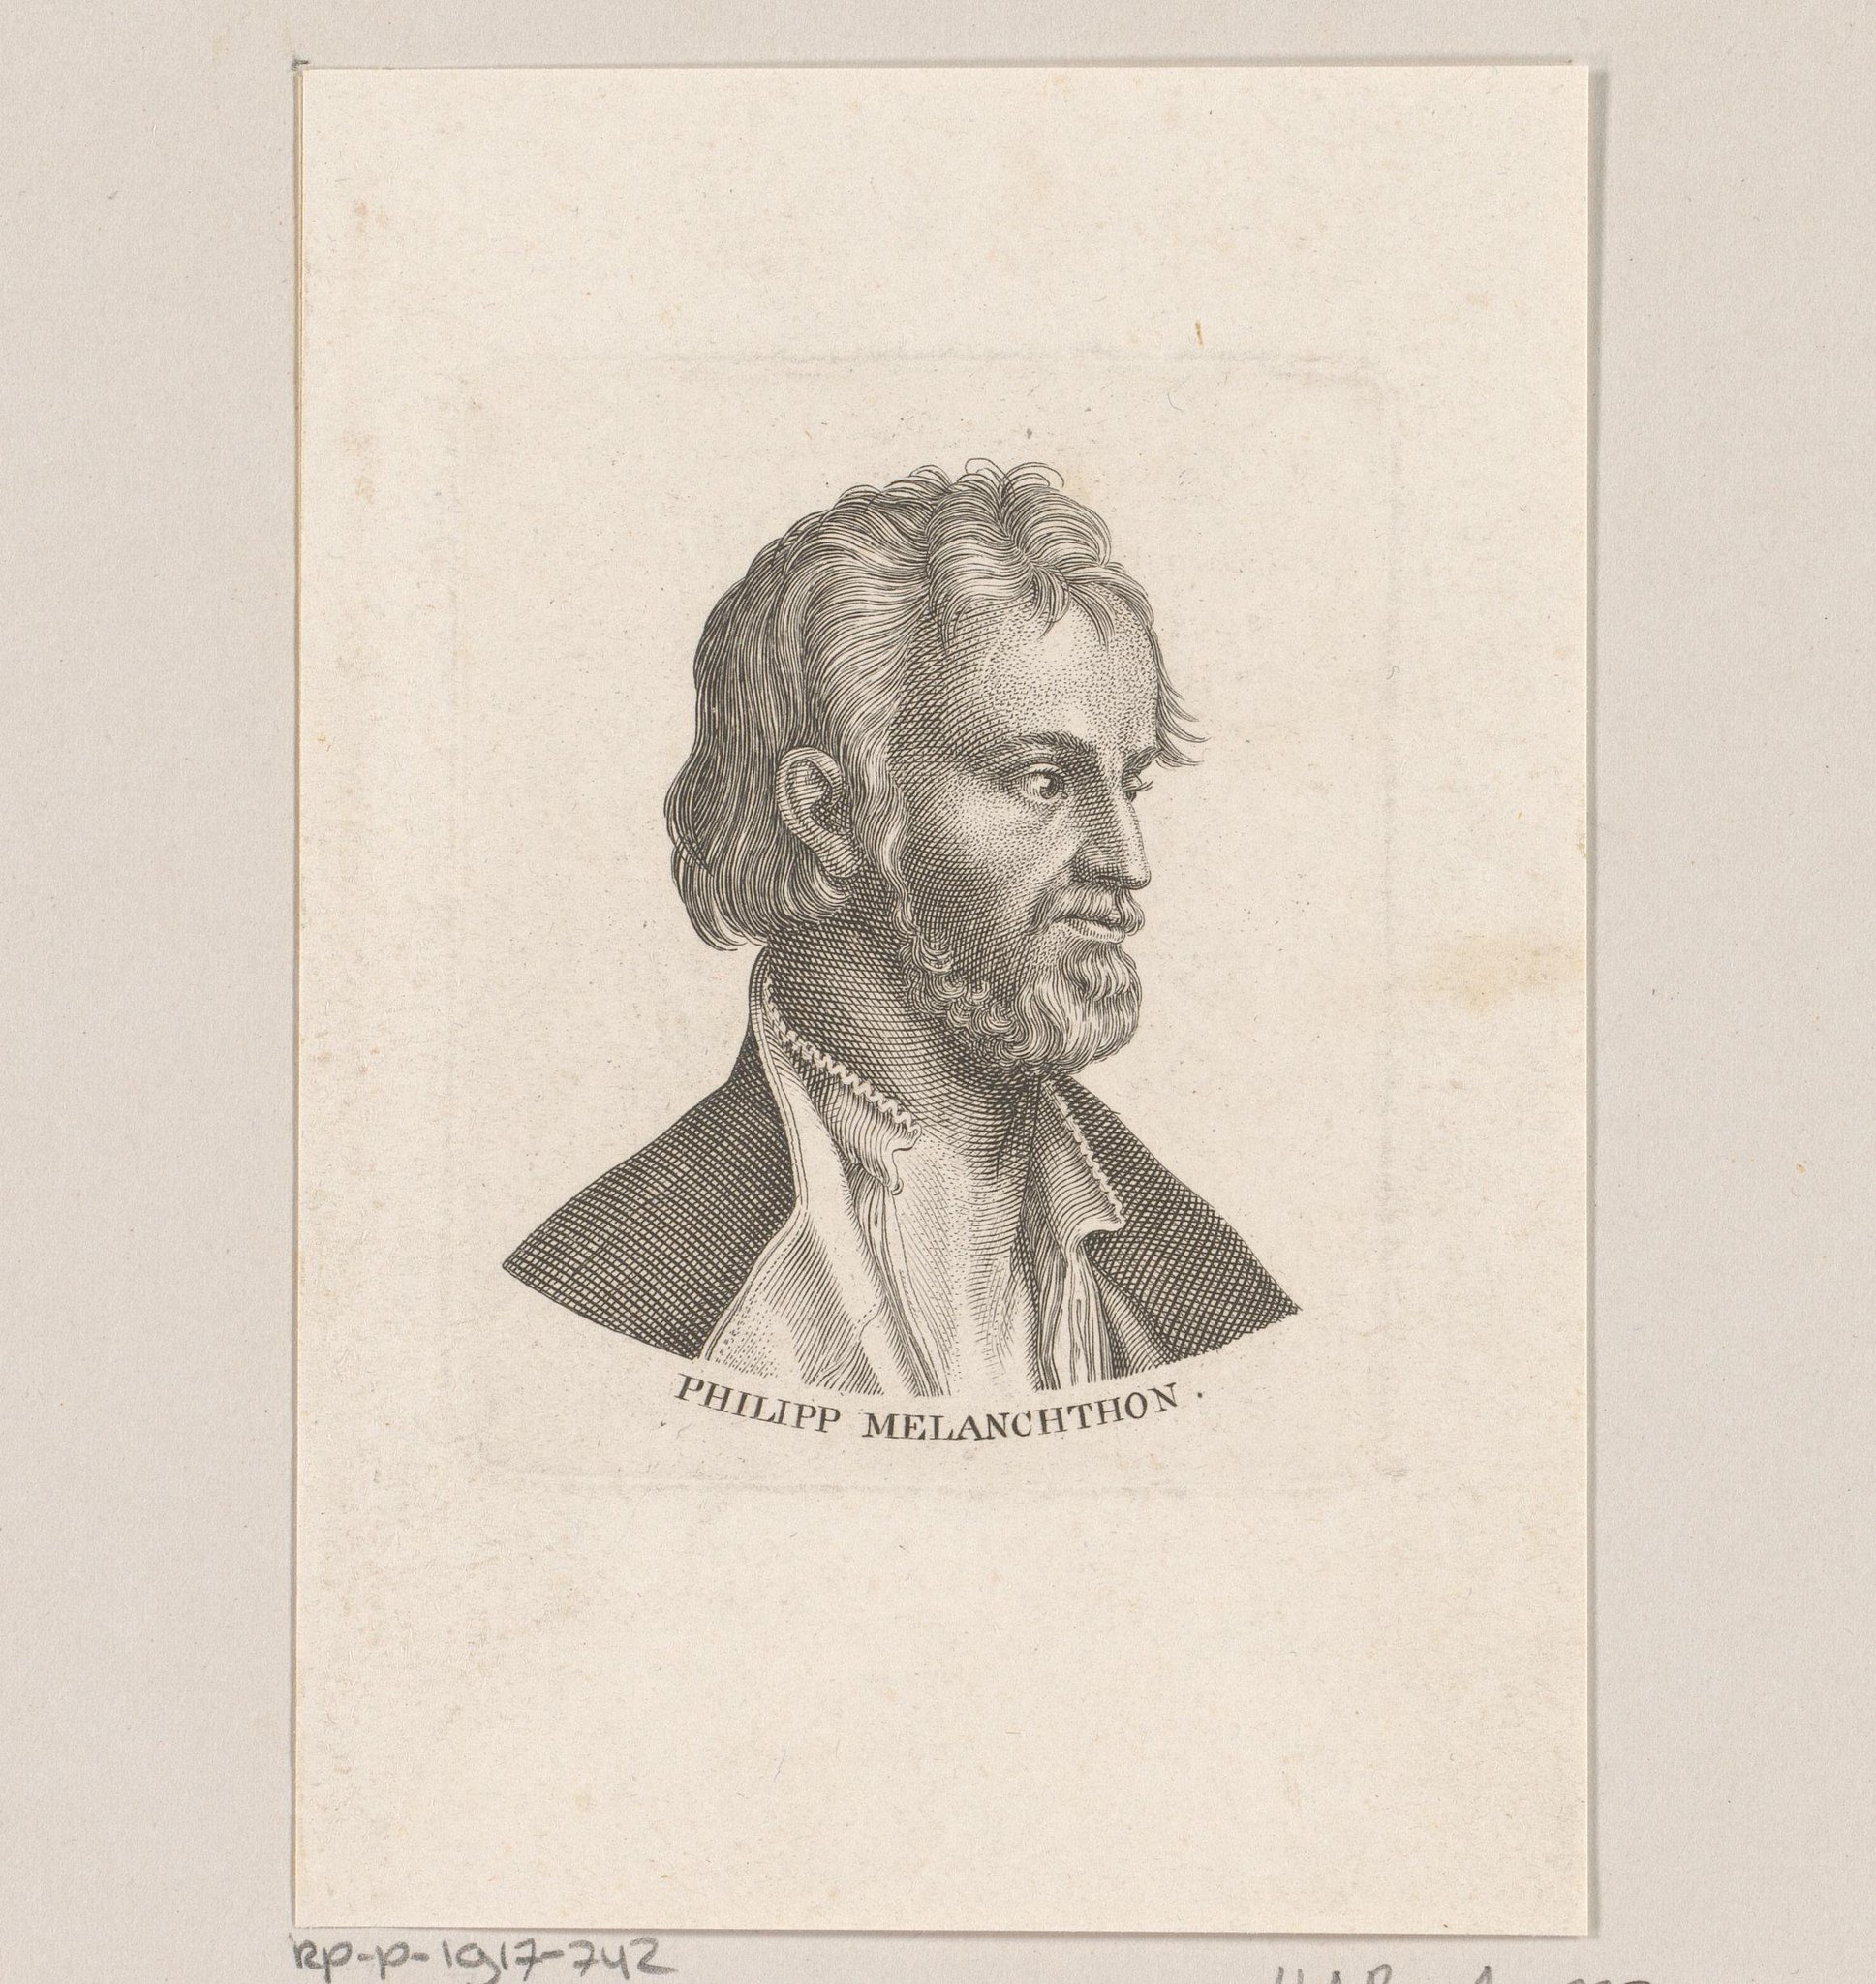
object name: print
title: Philipp Melanchthon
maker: ernst ludwig riepenhausen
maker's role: print maker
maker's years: 1765-1840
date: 1780-1840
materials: paper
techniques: engraving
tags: theologian, historical persons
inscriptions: collector's mark: Lugt 2228